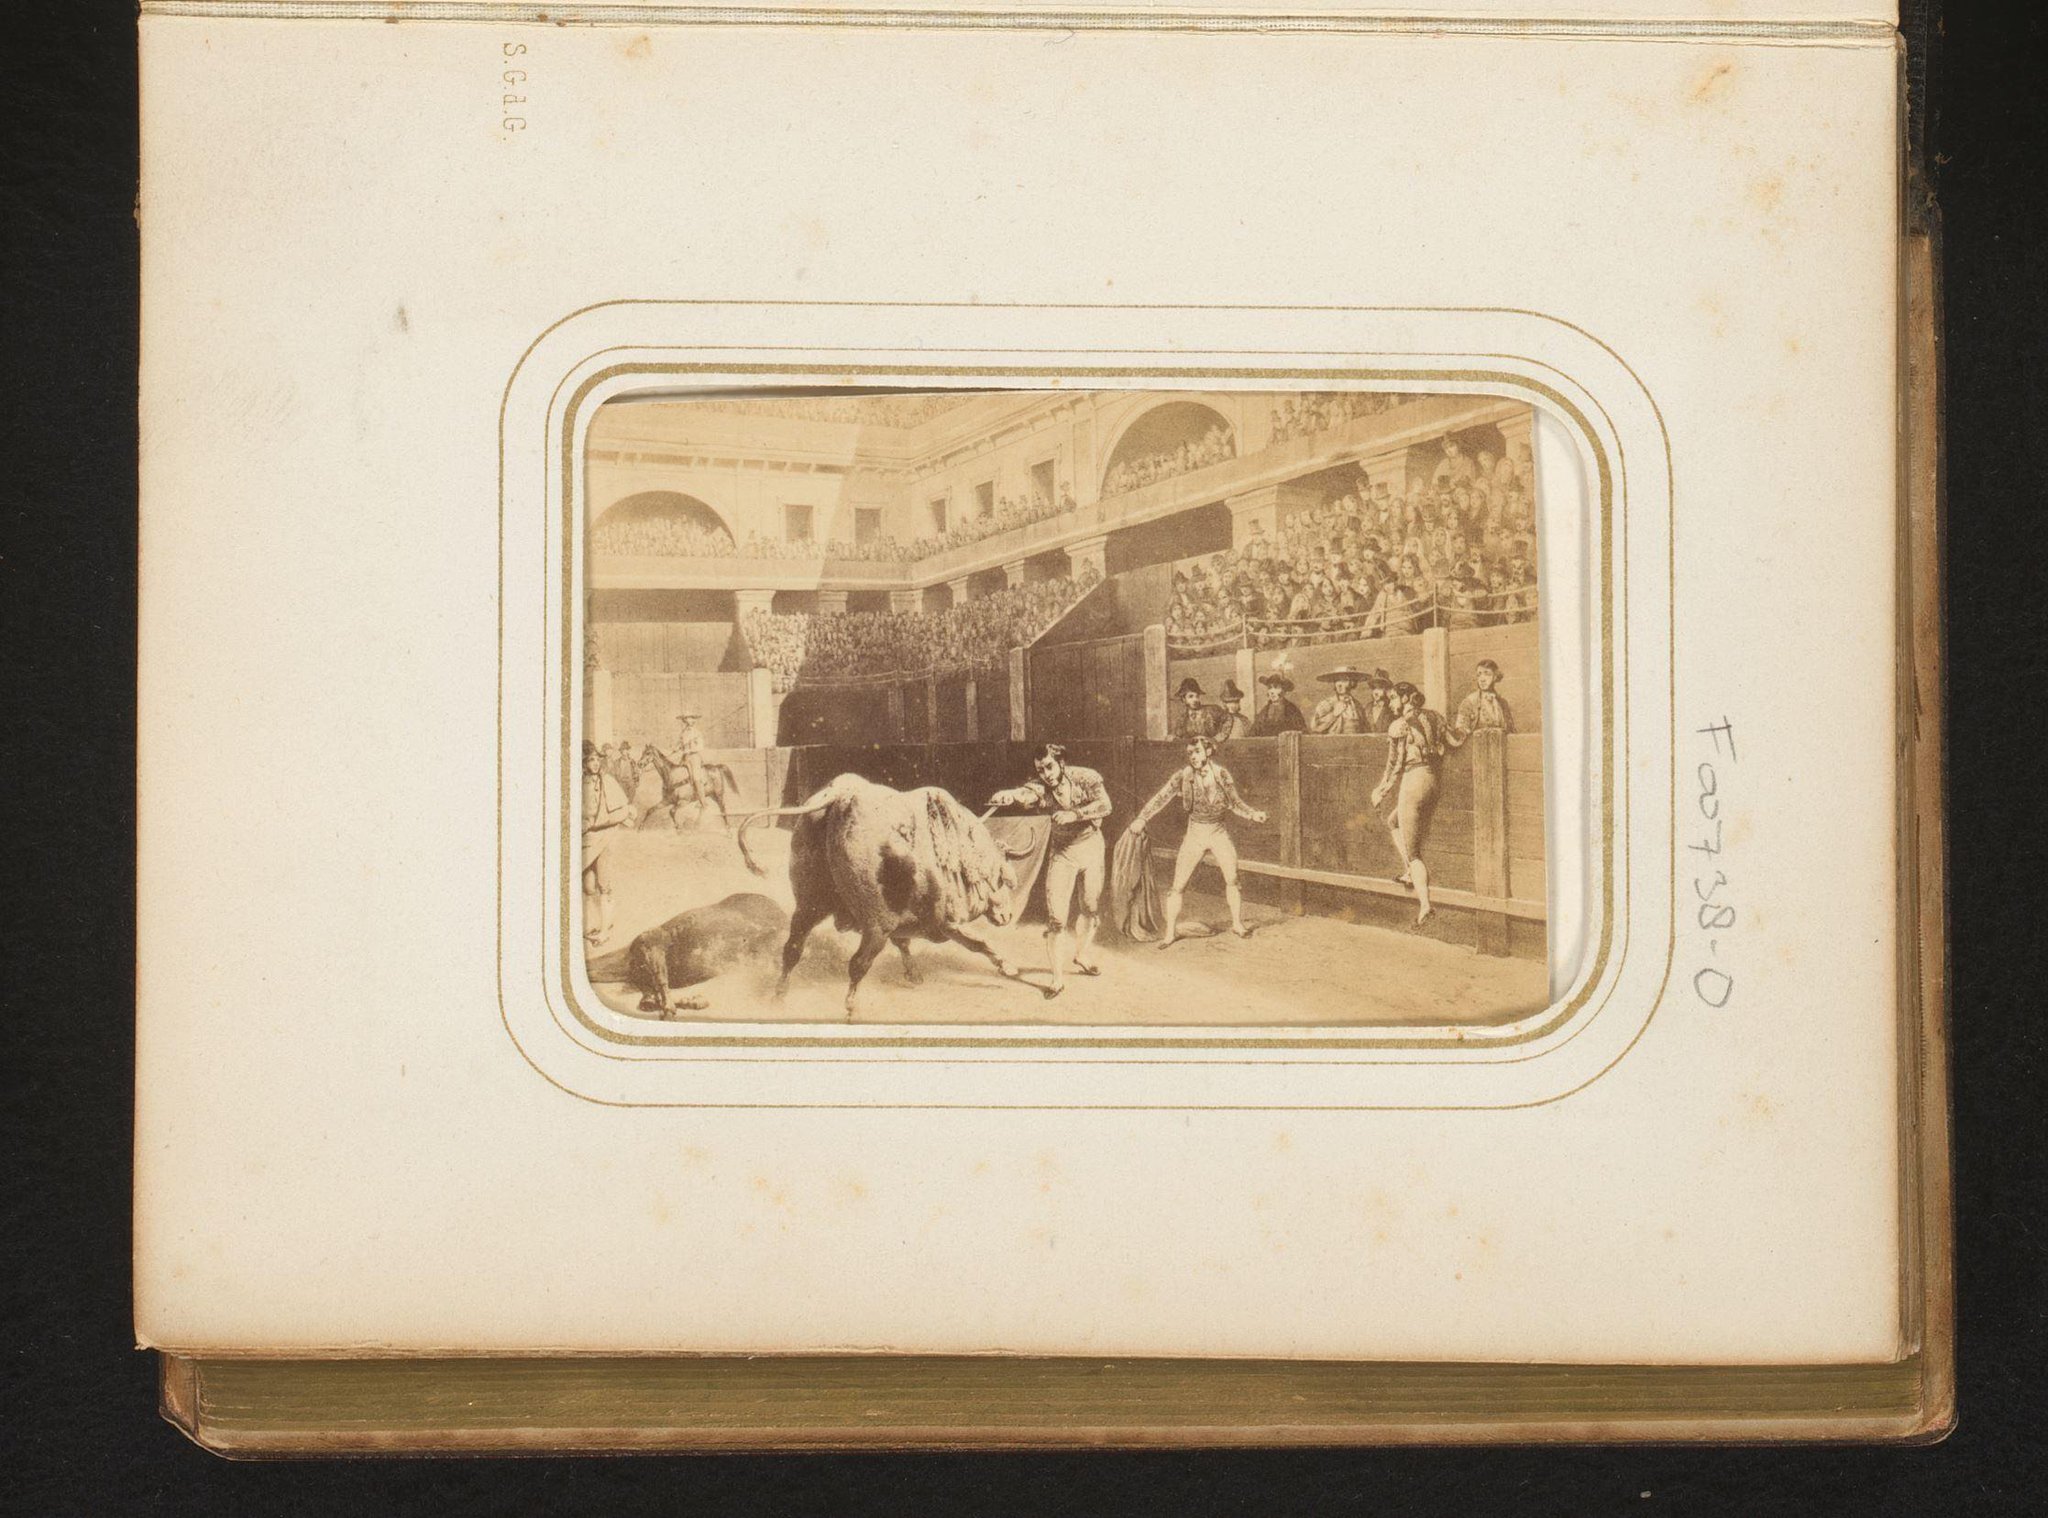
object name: photograph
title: Fotoreproductie van een schilderij van een stierengevecht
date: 1850-1884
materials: cardboard, photographic support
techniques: albumen print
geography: paris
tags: bullfight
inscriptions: inscription: ‘PHOTOGRAPHIE GOUPIL & Cie/ PARIS, 19, Bd Montmartre./ LONDRES - LA HAYE - BERLIN - NEW YORK’, inscription: ‘Breveté S.G.D.G.’